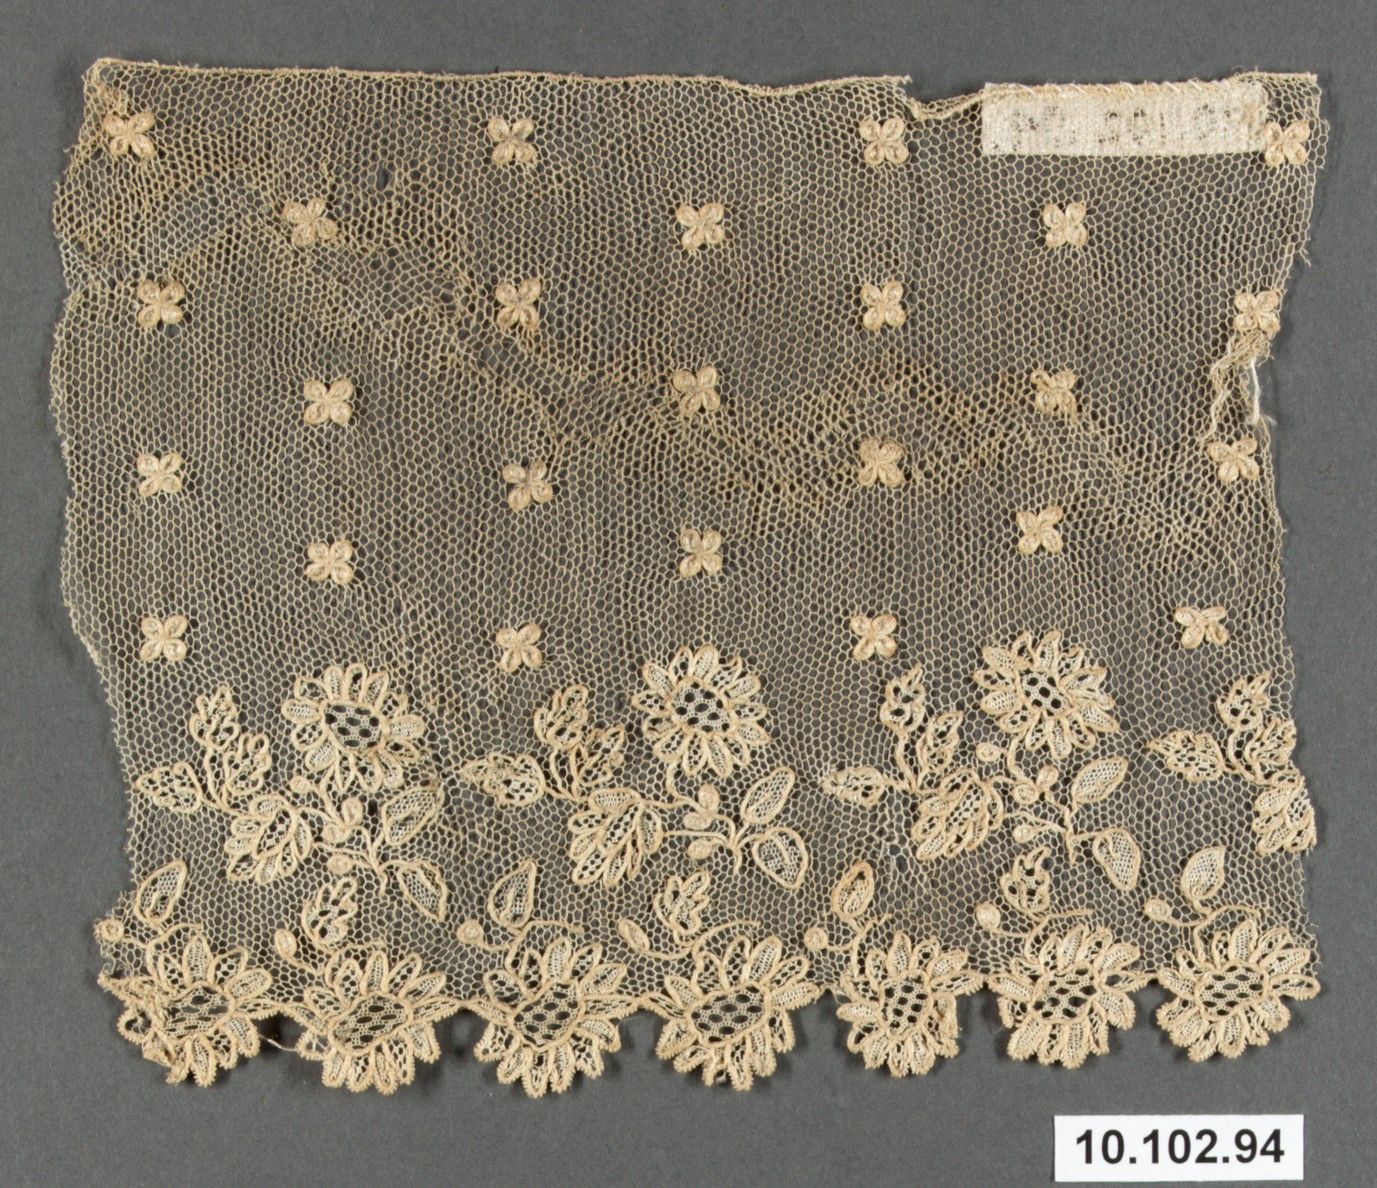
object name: fragment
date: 1801-1900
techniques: lace